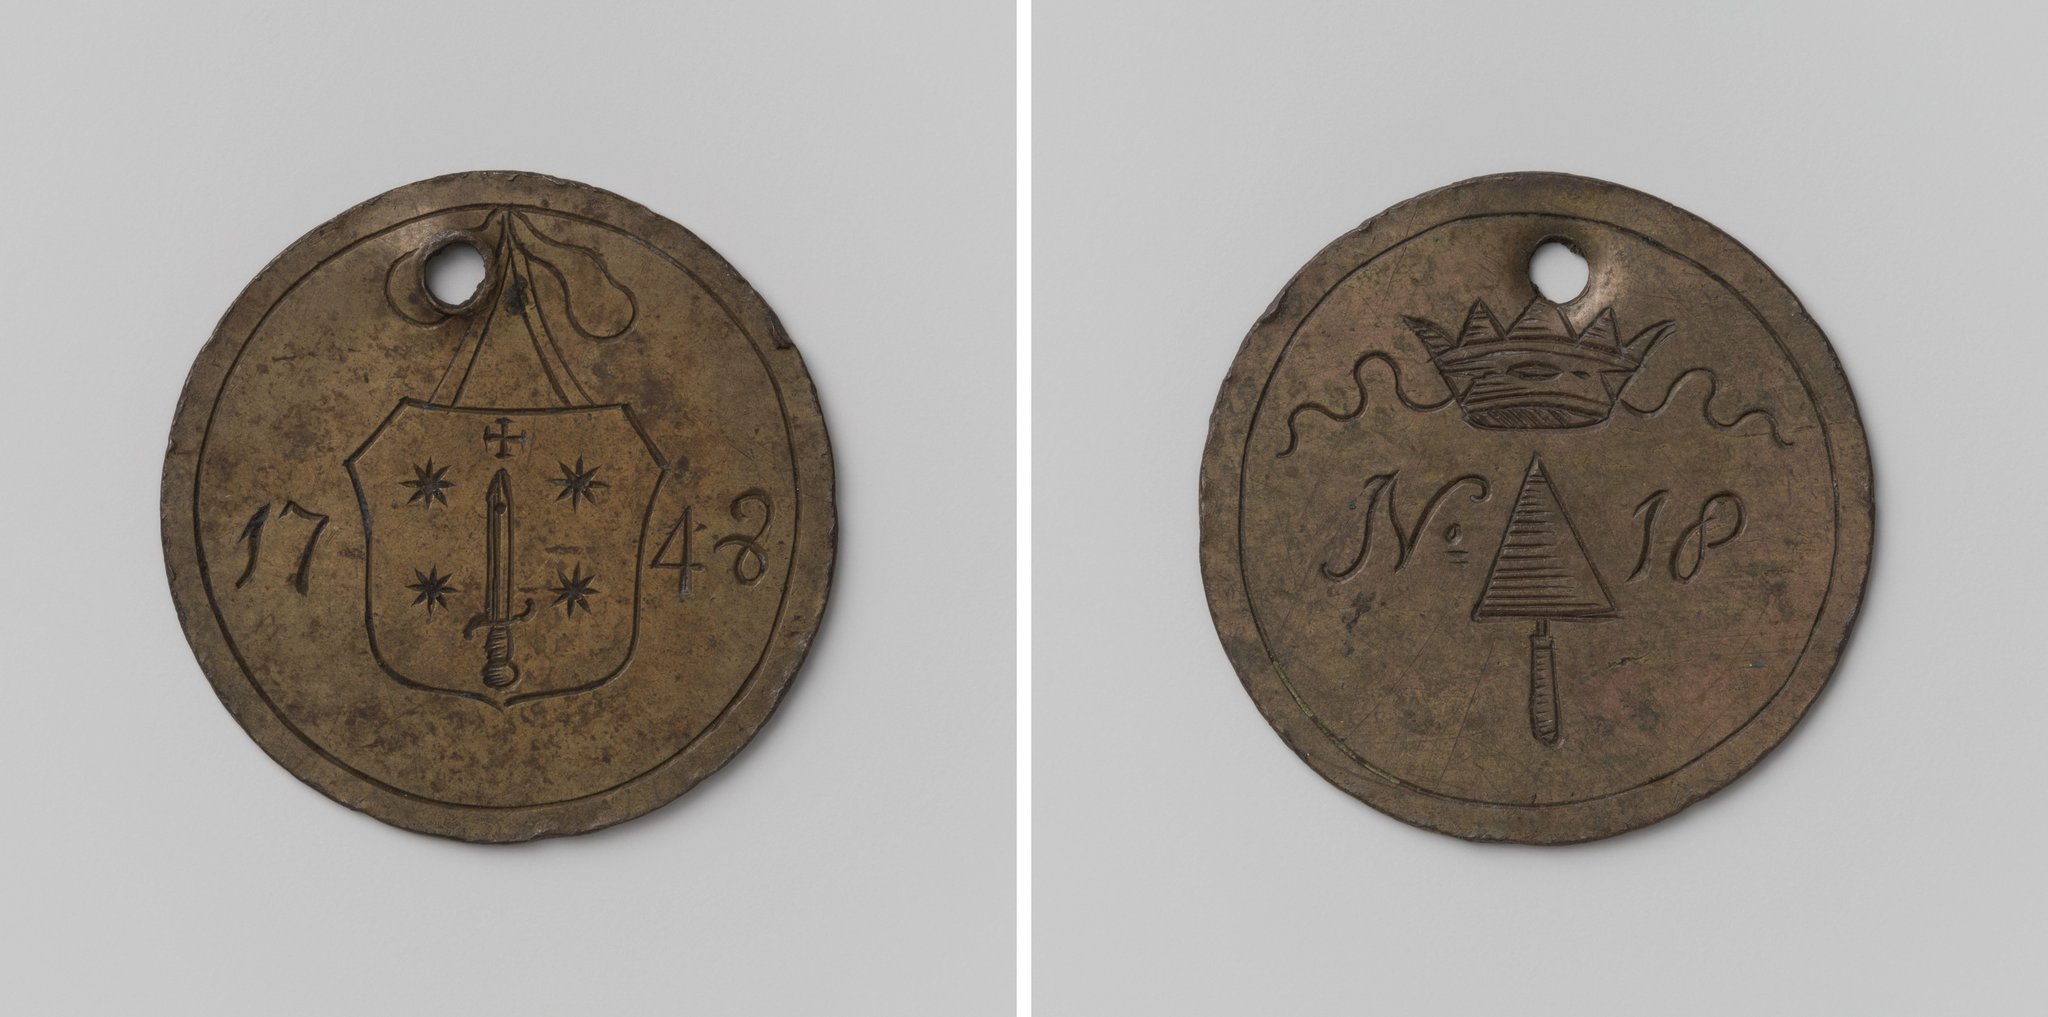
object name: medal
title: Metselaarsgilde van Haarlem, gildepenning met no. 18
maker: Anonymous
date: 1748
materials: copper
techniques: engraving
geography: haarlem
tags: haarlem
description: Koperen penning met gat erin. Voorzijde: wapenschild hangend aan lint tussen jaartal. Keerzijde: gekroonde troffel tussen opschrift: No. 18